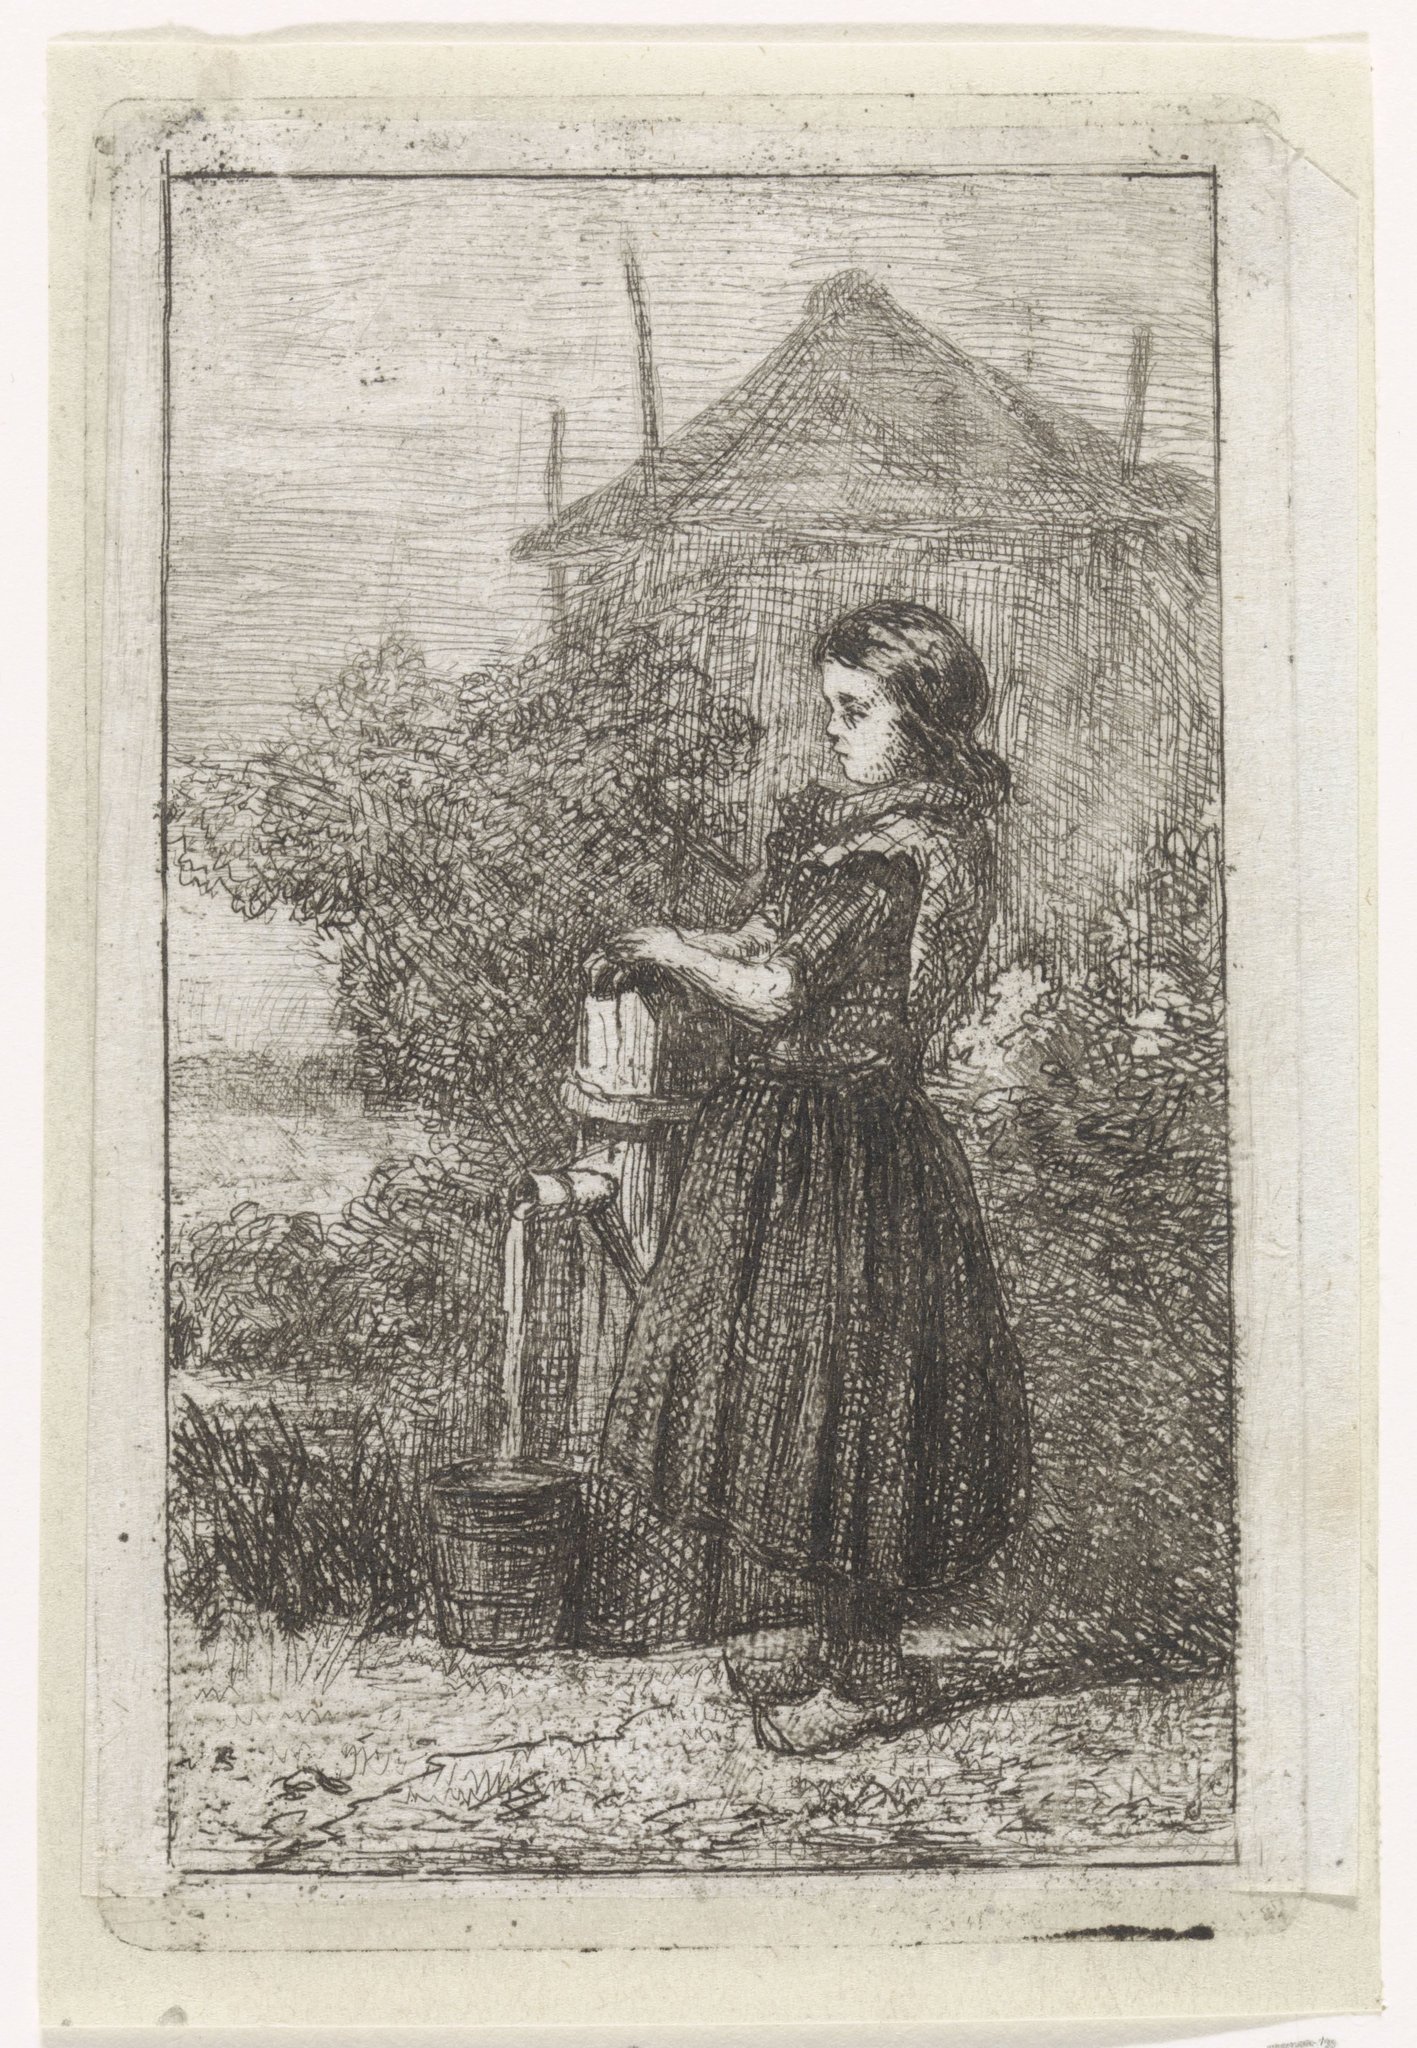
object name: print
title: Meisje bij een waterpomp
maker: kornelis jzn de wijs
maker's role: print maker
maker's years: 1832-1896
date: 1842-1884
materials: paper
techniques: etching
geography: netherlands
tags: girl (child between toddler and youth), utilitarian, public pump or water fountain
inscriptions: collector's mark: Lugt 2228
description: Een meisje bij een waterpomp. Op de achtergrond een hooiberg.